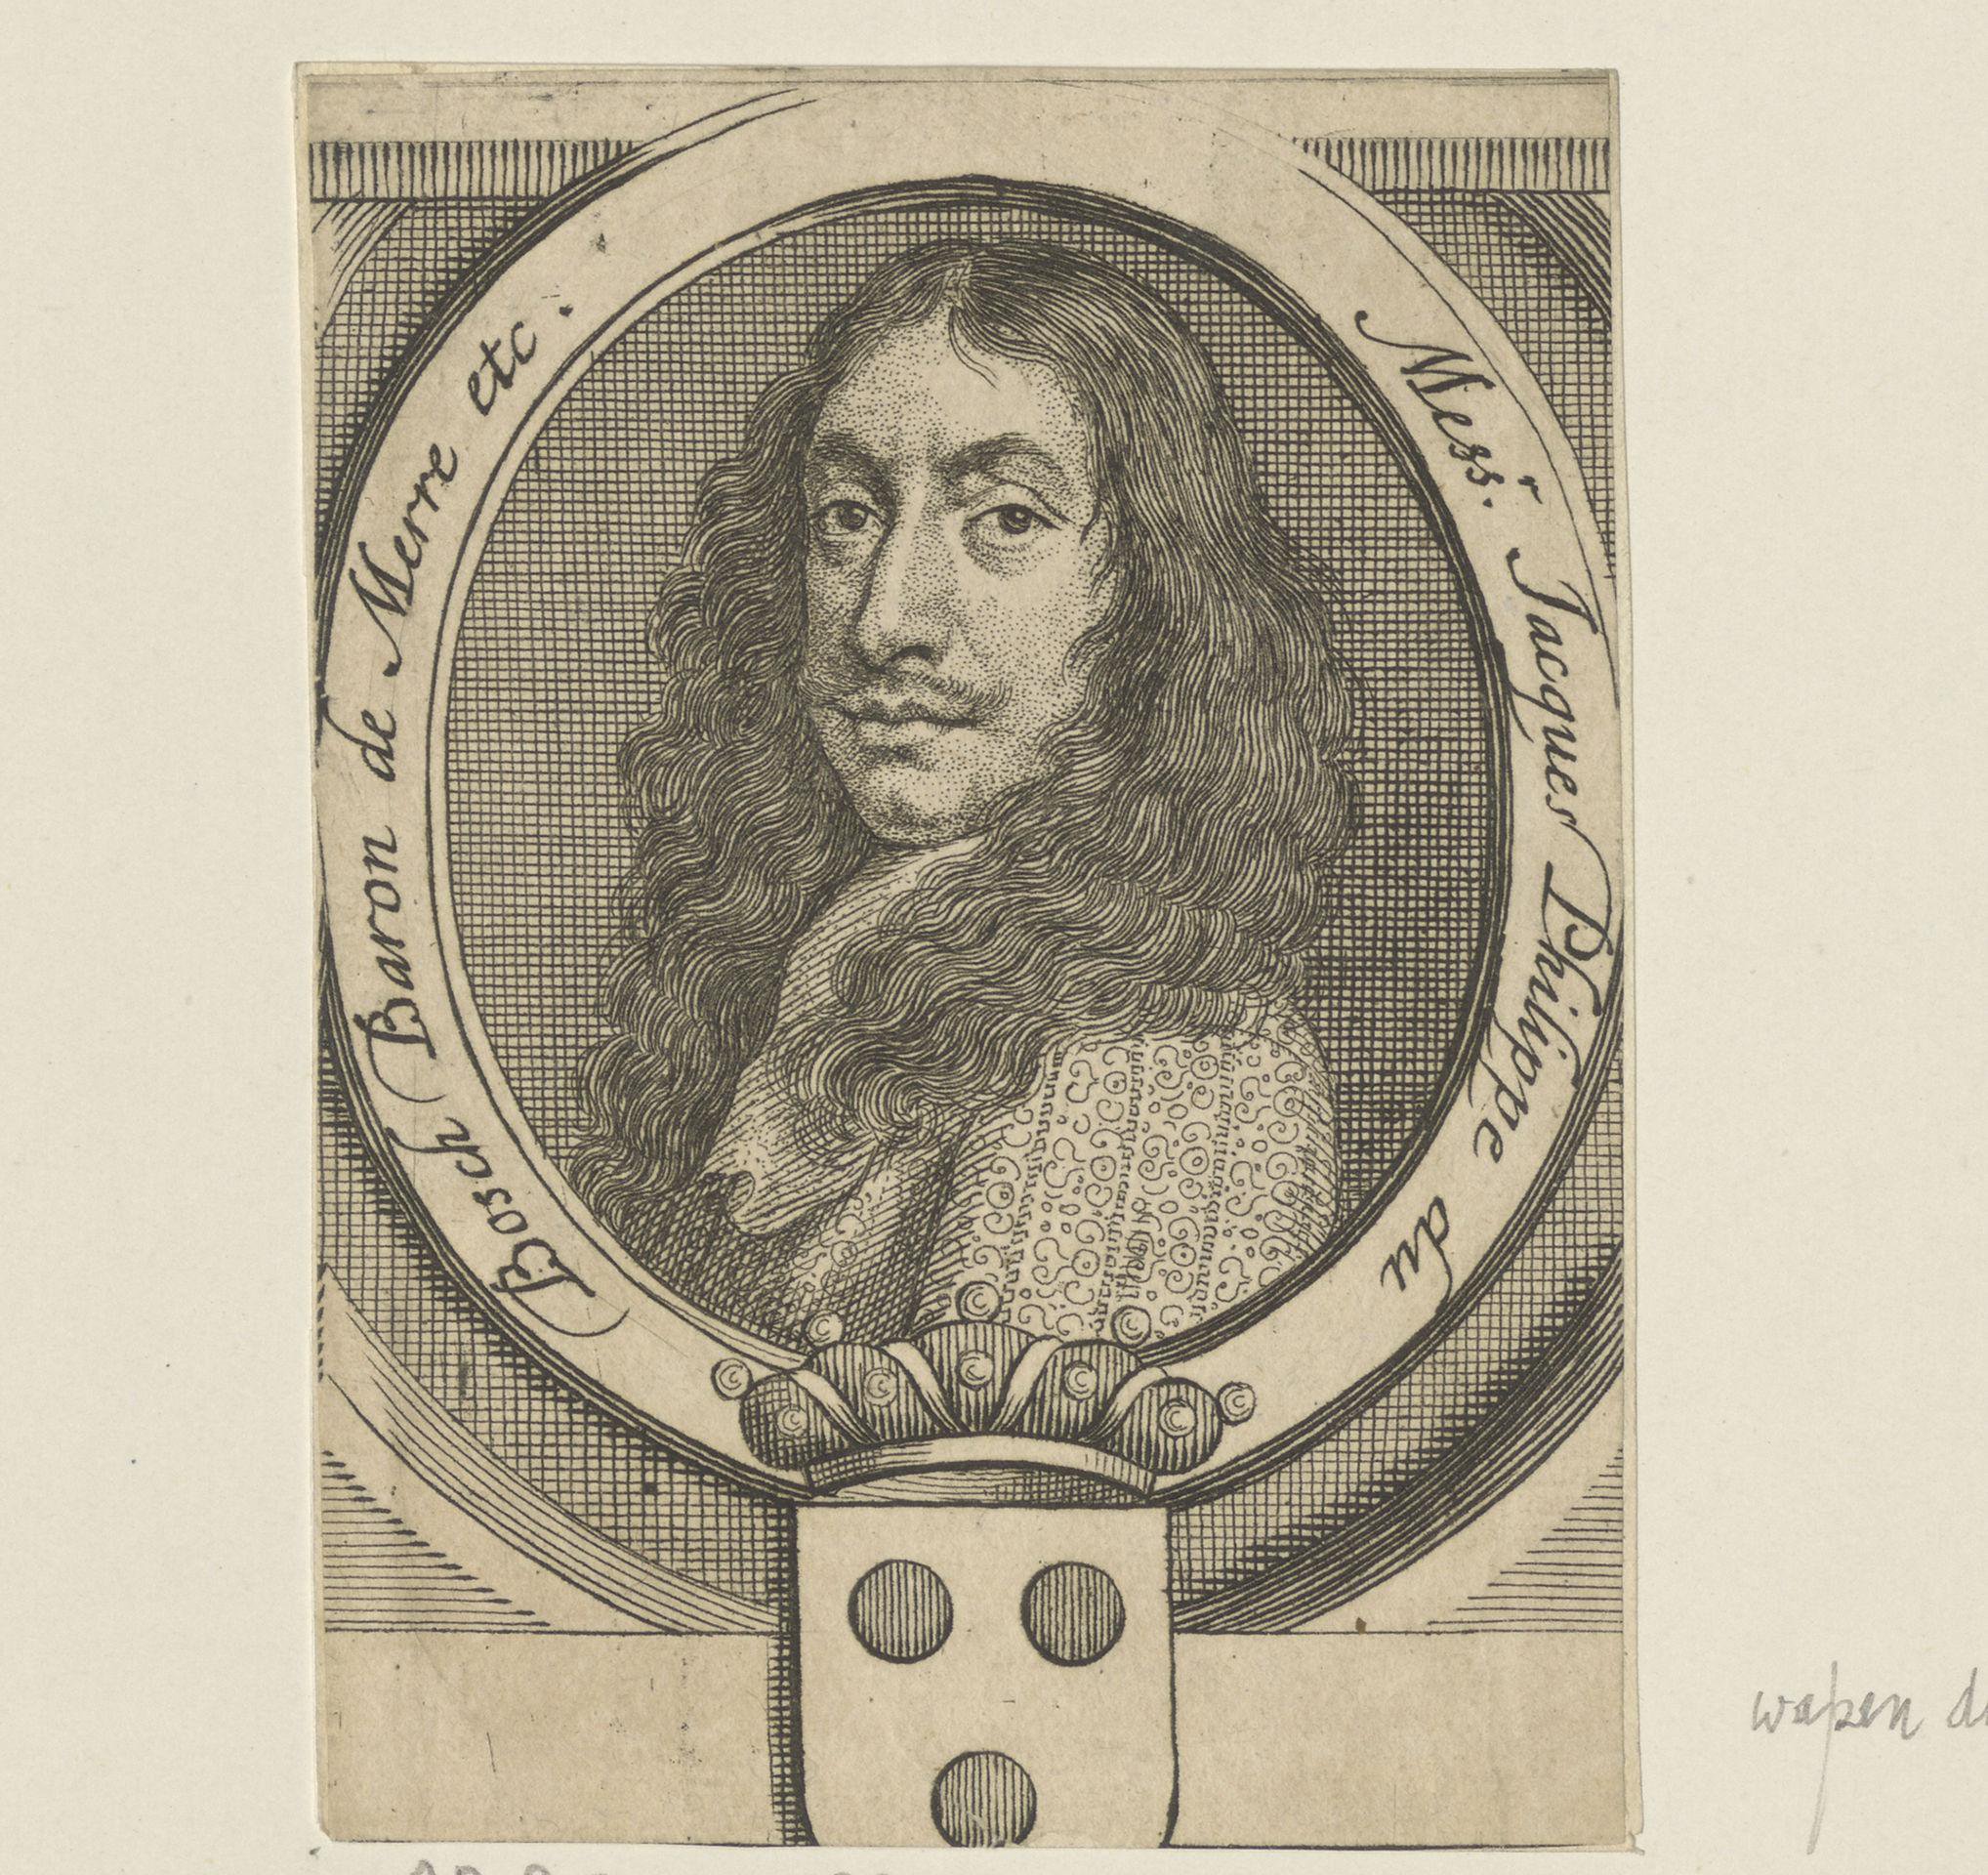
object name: print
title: Portret van Jacques Philippe du Bosch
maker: Anonymous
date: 1650-1749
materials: paper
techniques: engraving, etching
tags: historical persons, nobility and patriciate; chivalry, knighthood